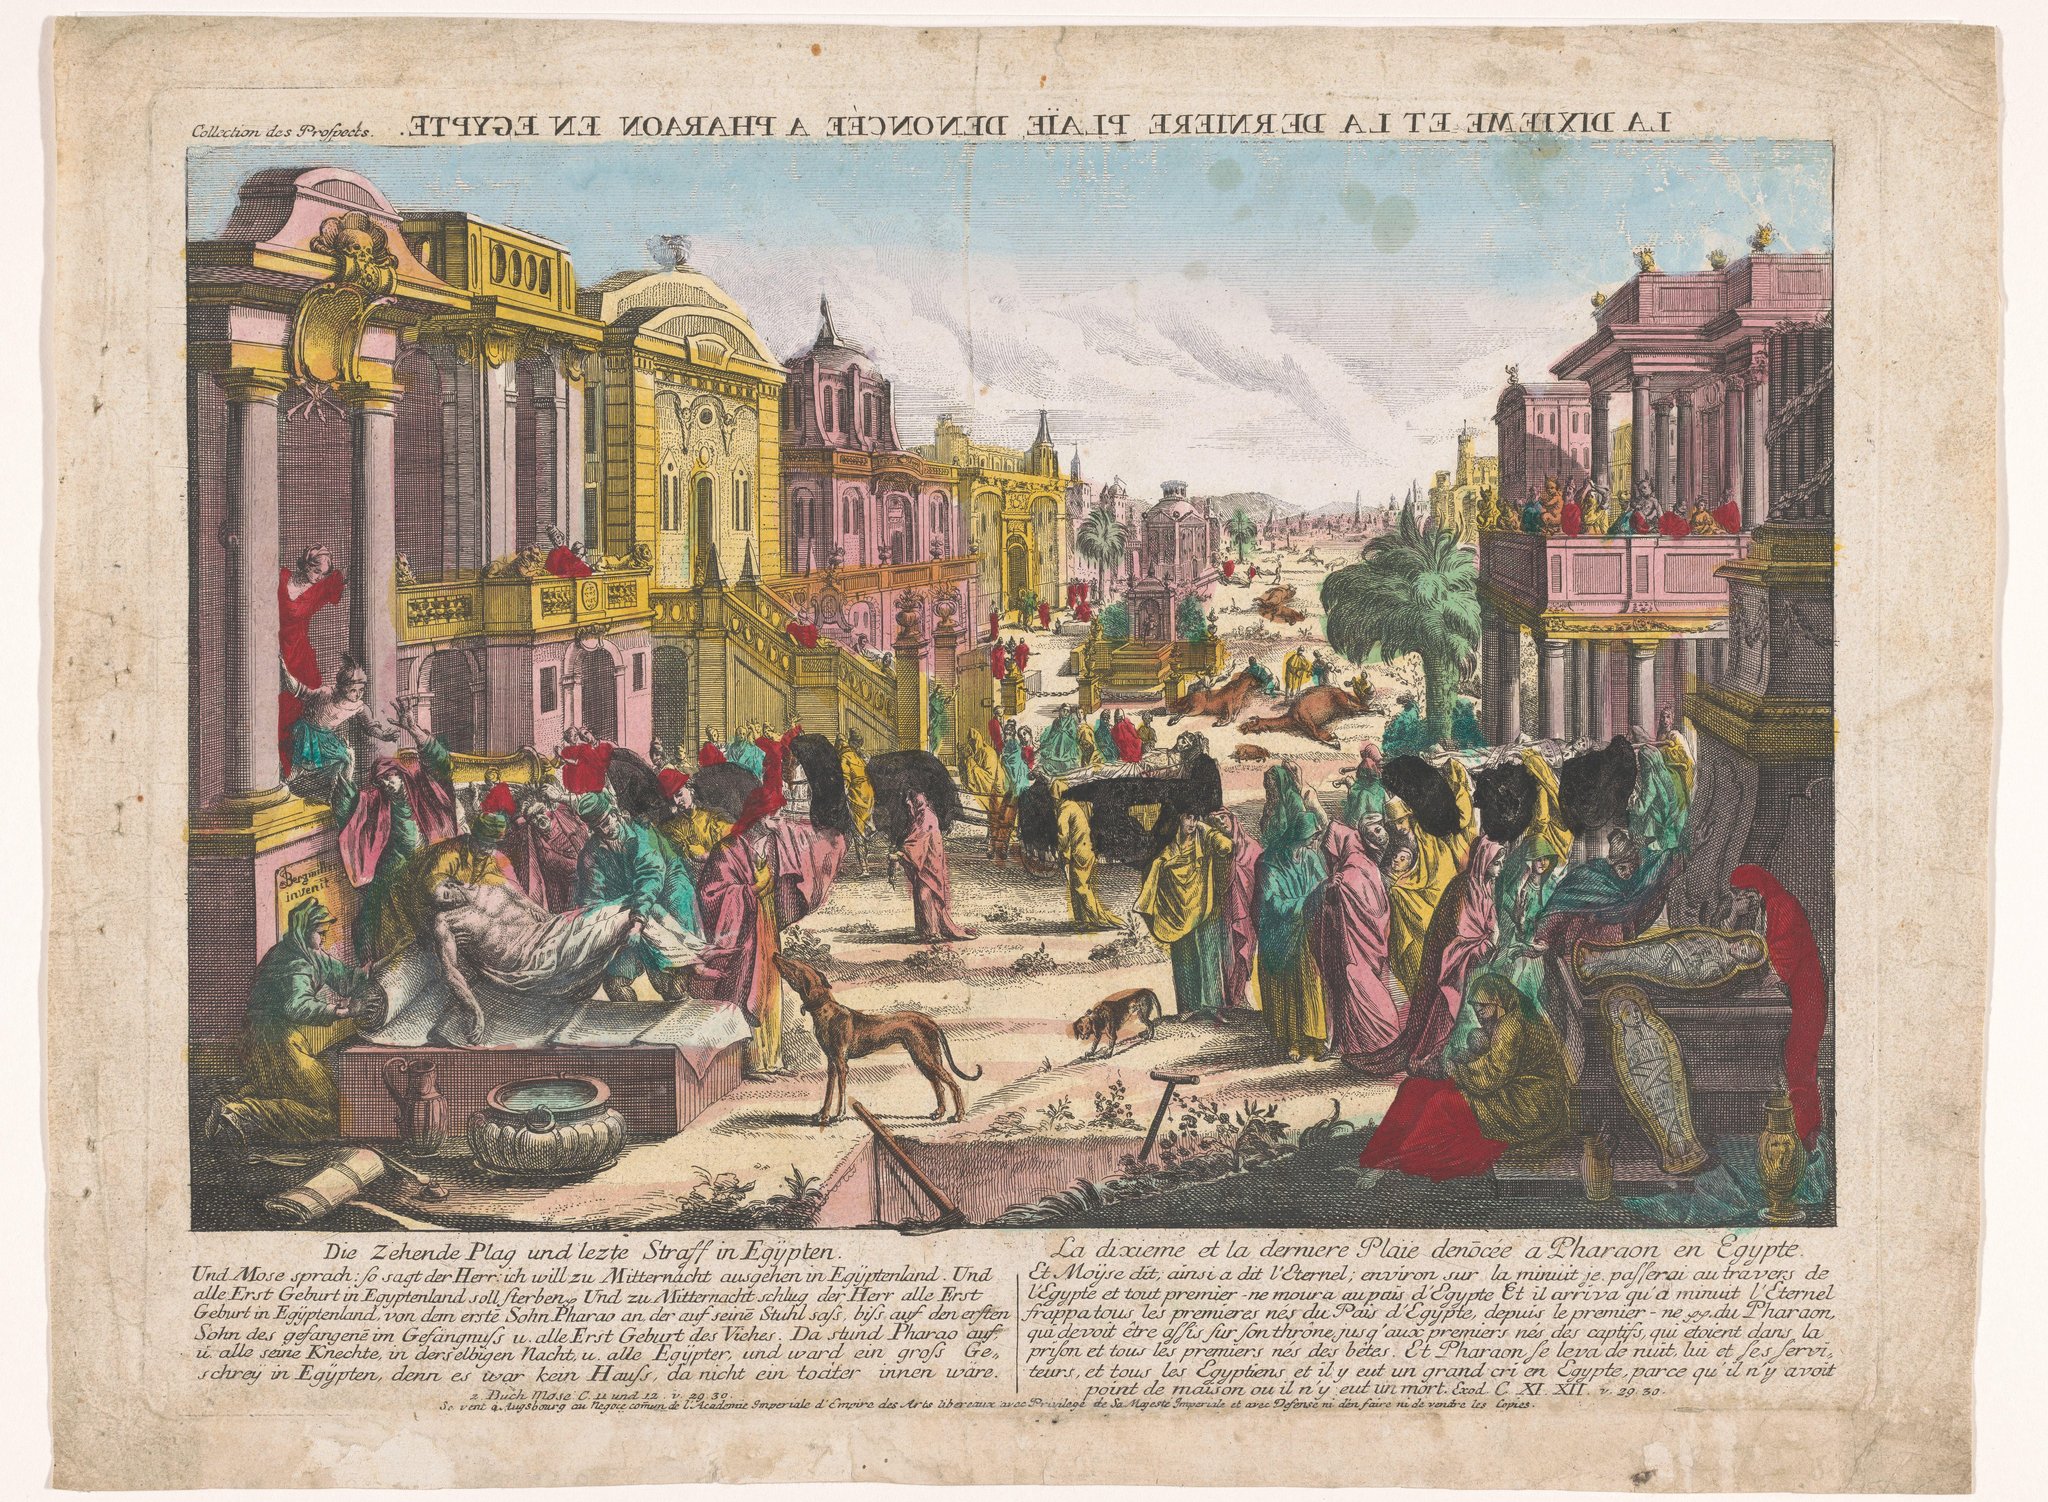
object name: print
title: Die zehende Plag und lezte Straff in Egypten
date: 1755-1779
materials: paper, watercolor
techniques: brush, etching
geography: augsburg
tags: cortege, funeral procession, the plague of the first-born: the destroying angel passes through the land and kills every egyptian first-born of man and animal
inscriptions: collector's mark: Lugt 2228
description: De plaag van de dood van de eerstgeborenen bij de Egyptenaren. Gezicht op een plein in een stad met treurende mensen, rouwstoeten en begrafenisrituelen. Op de achtergrond dode dieren. Onder de afbeelding uitleg in het Duits en het Frans.